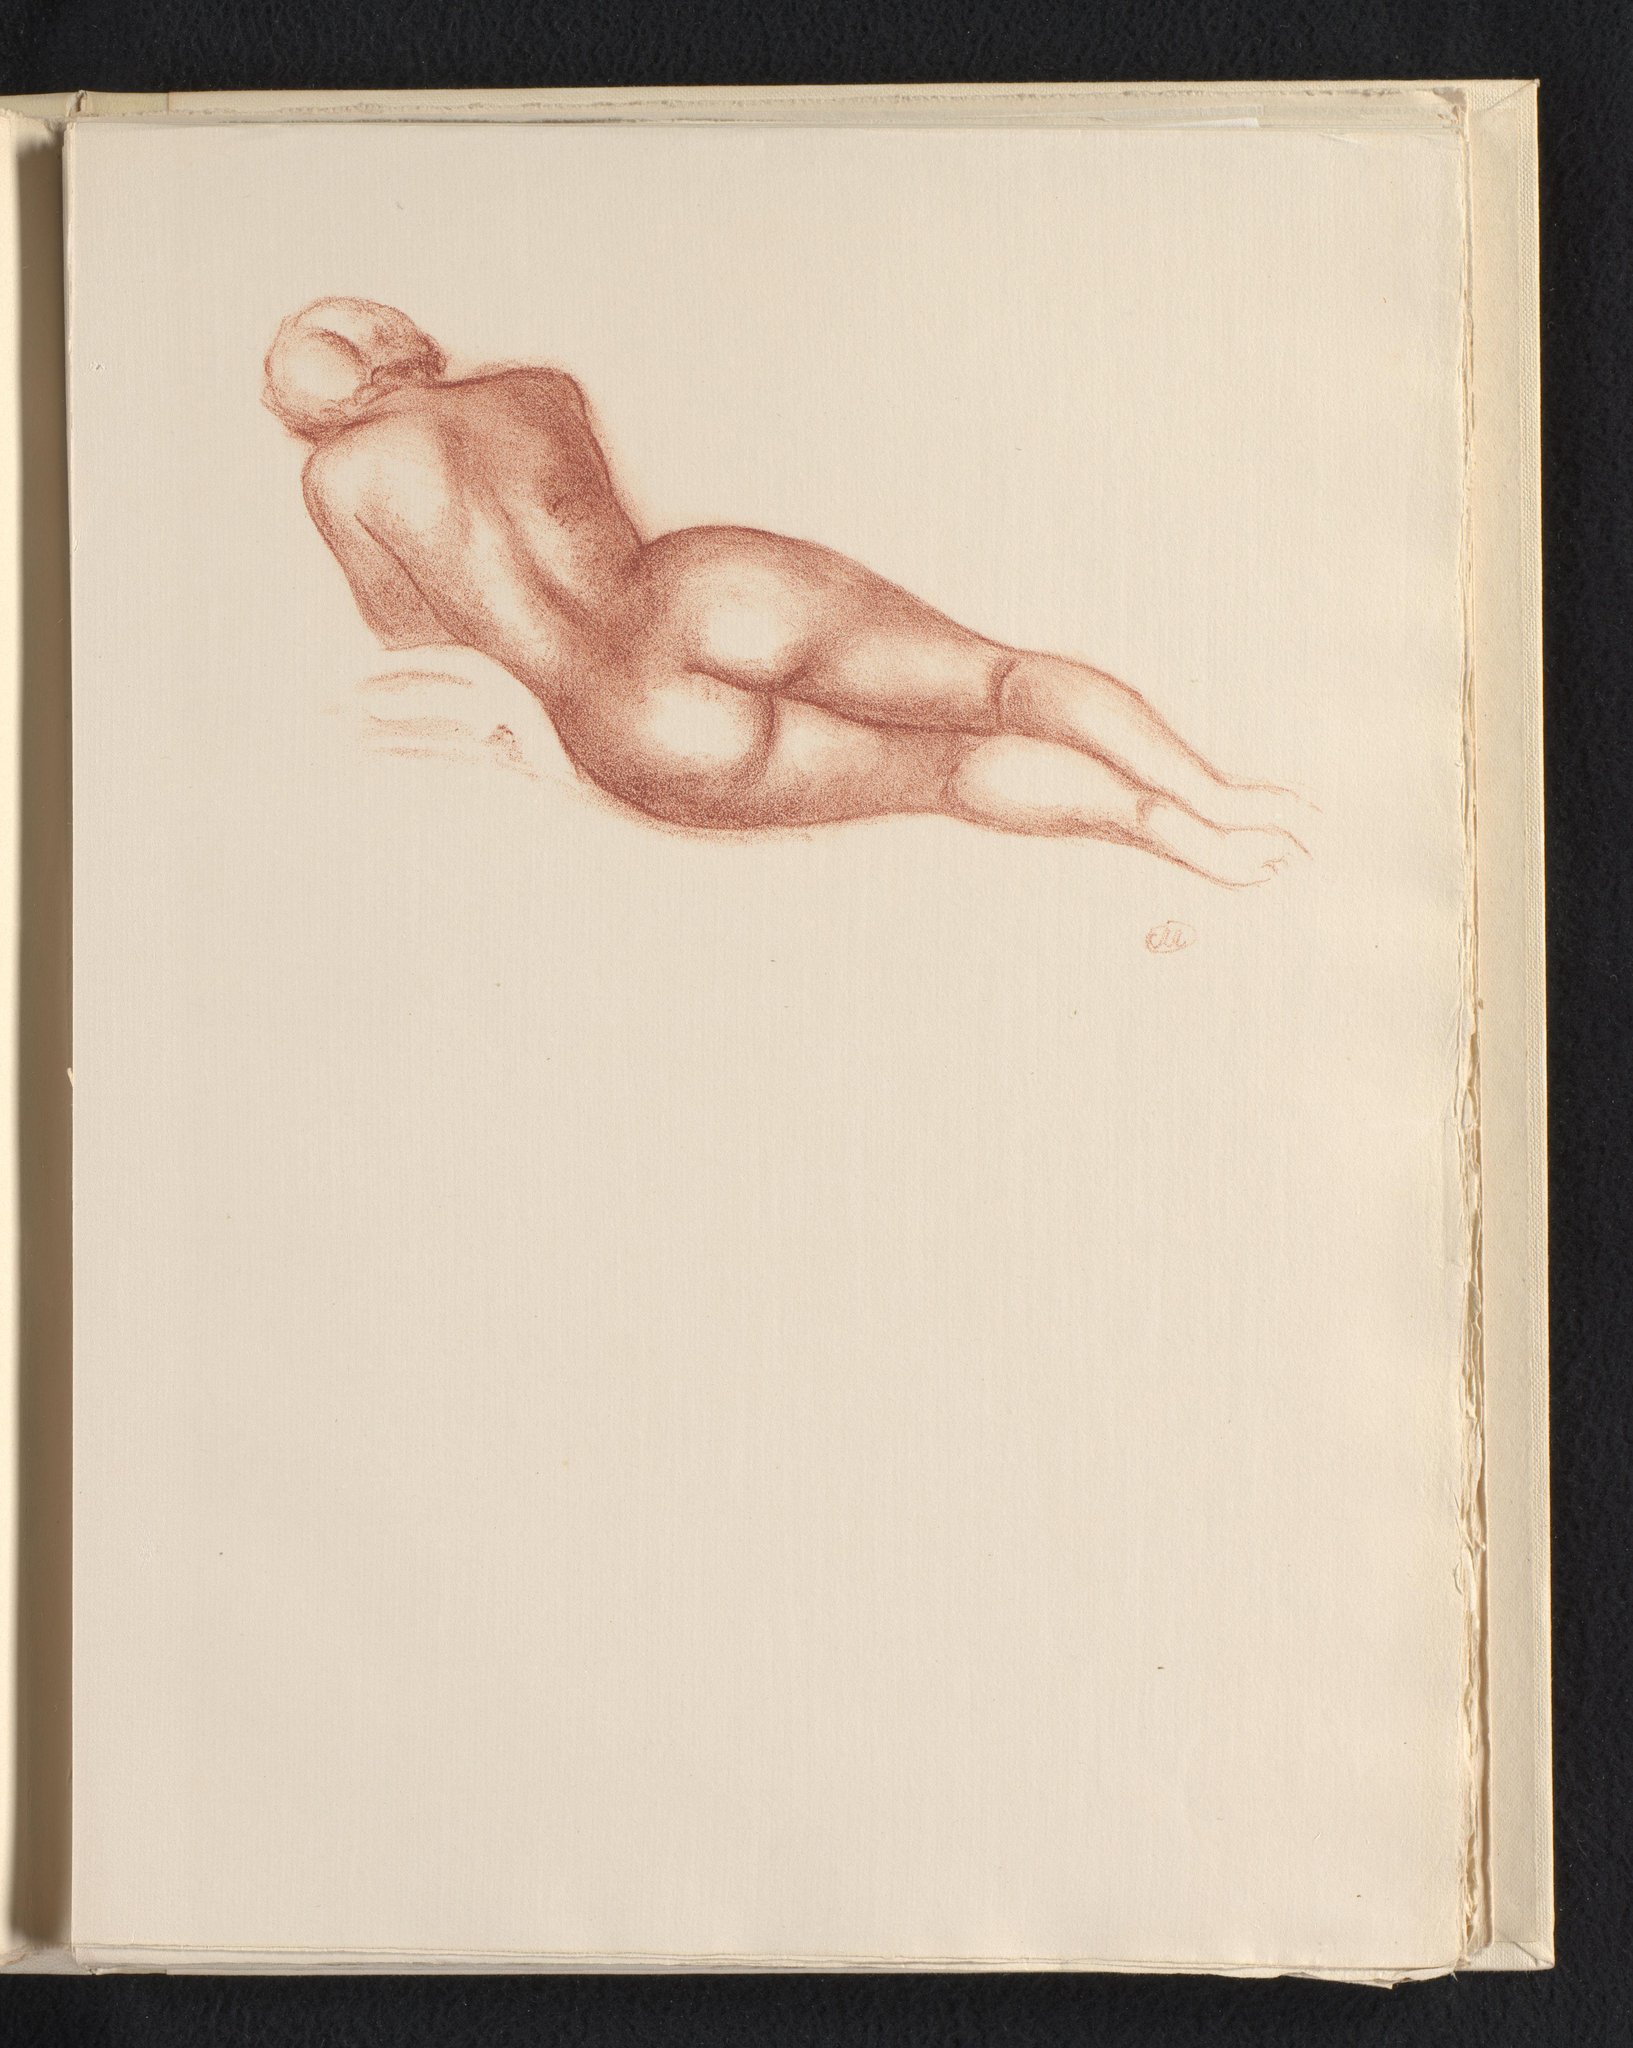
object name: book illustration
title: Liggende naakte vrouw, op de rug gezien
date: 1948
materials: paper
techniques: lithograph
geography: paris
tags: lying on one side, with uplifted upper part of the body and leaning on the arm - aa - female human figure, woman (showing herself) undressed, quasi-nude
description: Prent uit: Lucianus van Samosata. Dialogues des Courtisanes. [Vertaald uit het Grieks door] Charles Astruc. Parijs: s.n., 1948, deel van de suite met een extra afdruk van de prenten in sanguine.